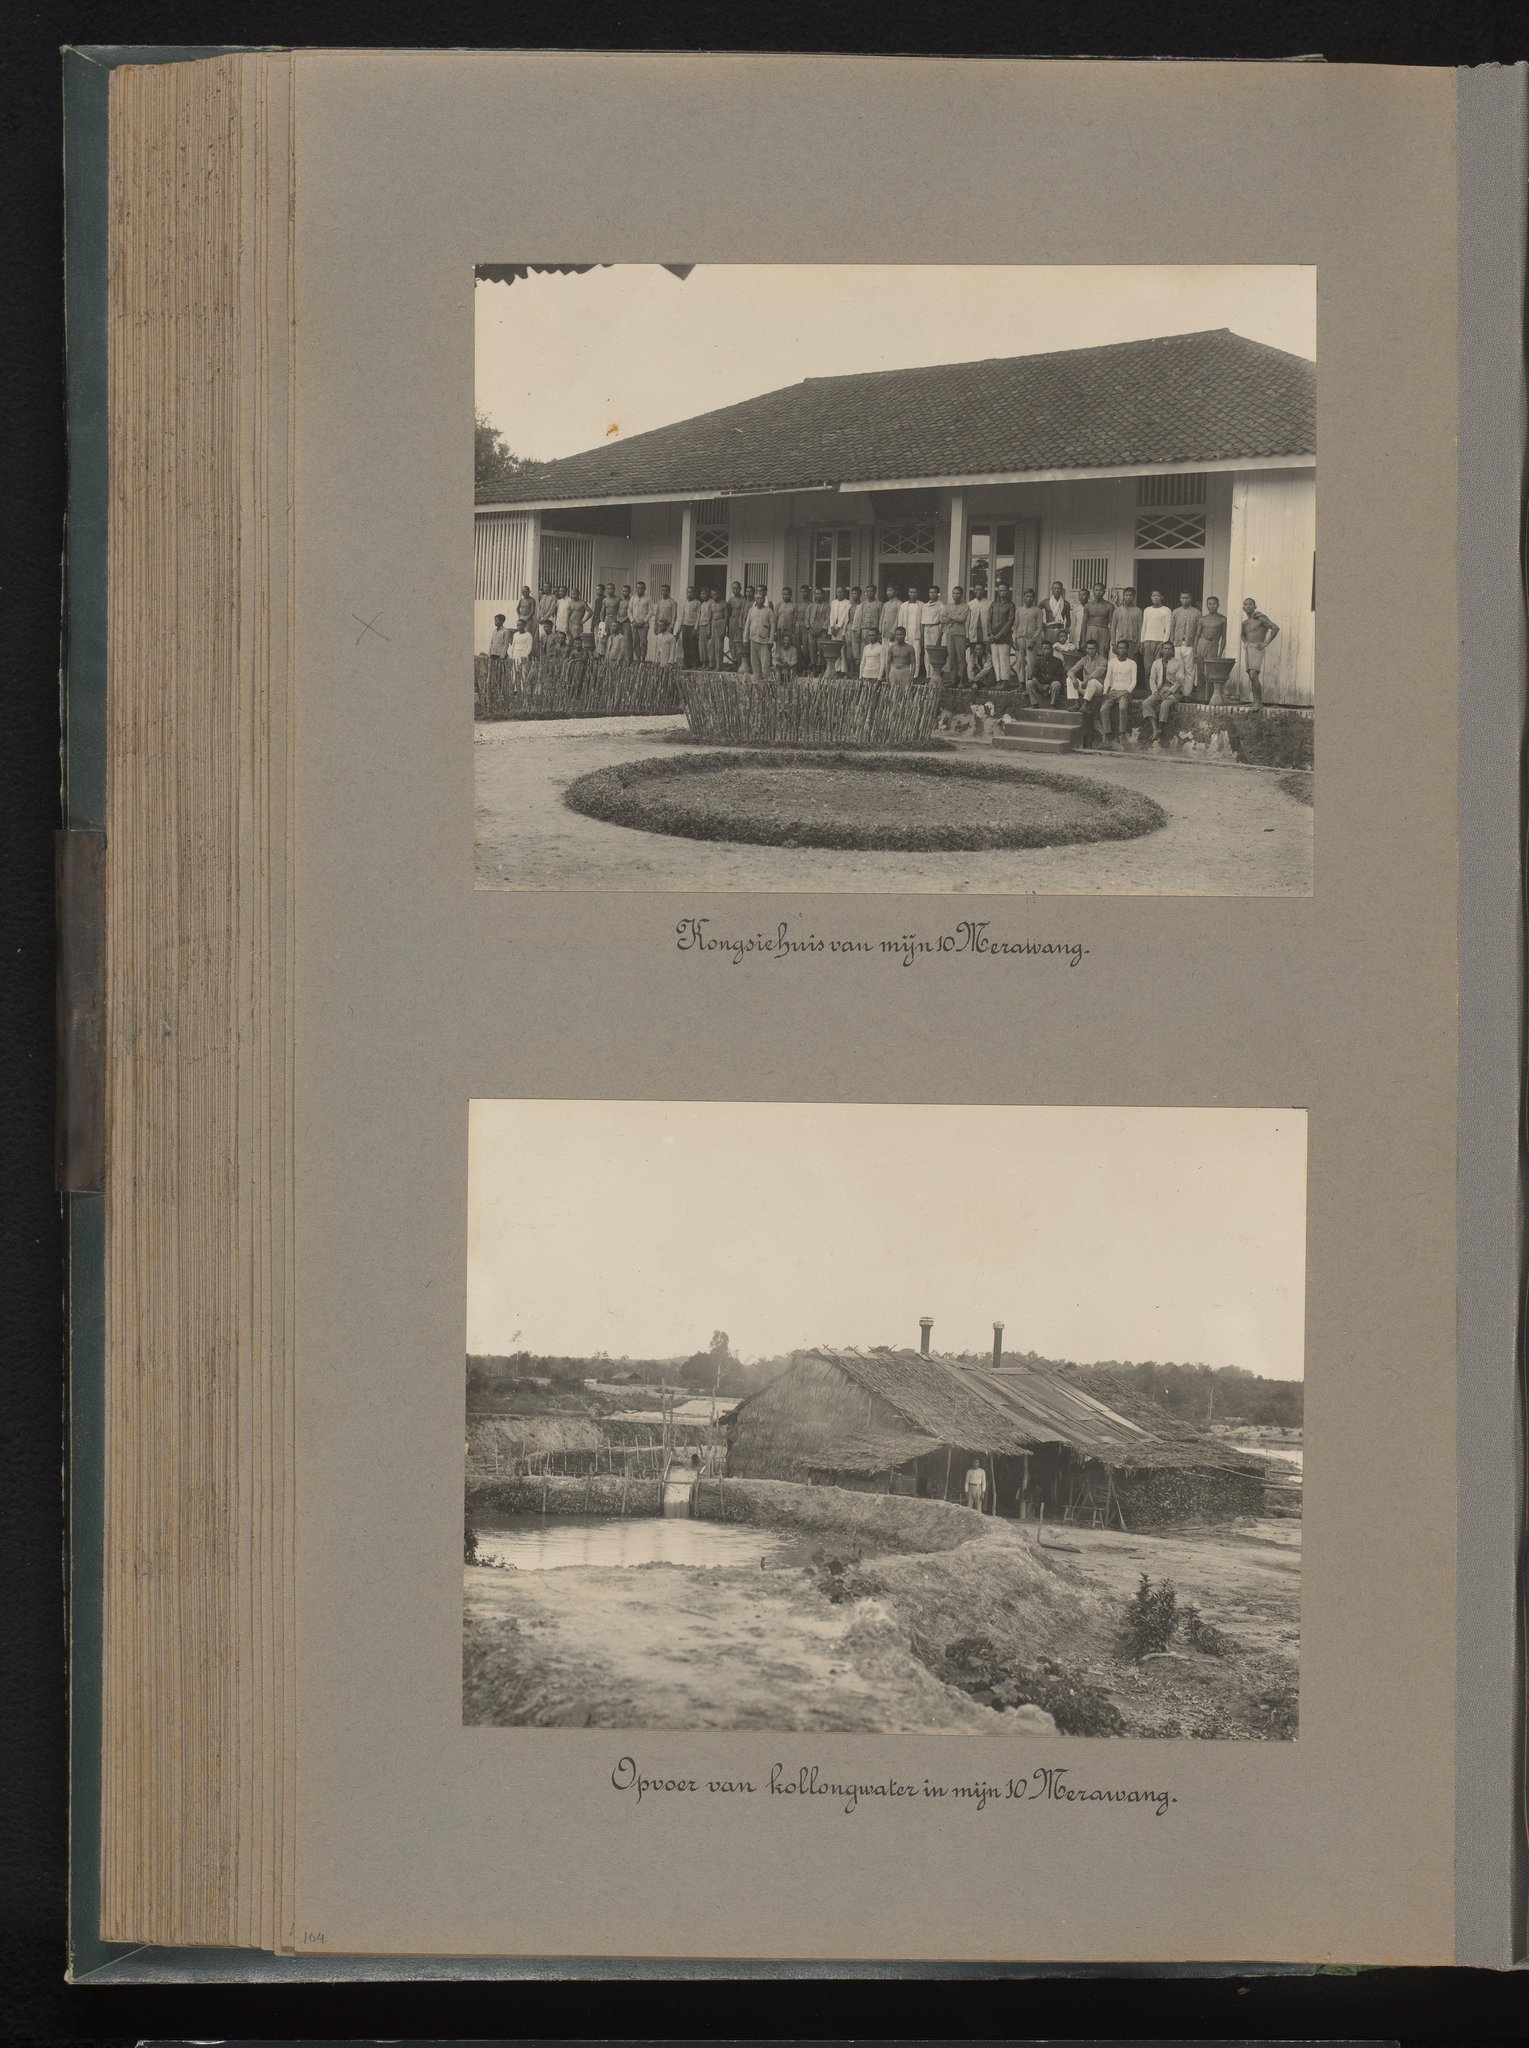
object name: photograph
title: Kongsihuis en waterinstallatie van de Banka-tinwinning te Merawang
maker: Anonymous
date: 1914-1919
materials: cardboard, photographic support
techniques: gelatin silver print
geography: bangka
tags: robert julius boers, colonial system, mining, modern professional organization, trade union, working class, labourers, hut, cabin, lodge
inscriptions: inscription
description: Albumblad met 2 foto's van contractarbeiders poserend voor een kongsihuis en een waterinstallatie van de Banka-tinwinning te Merawang. Onderdeel van het fotoalbum aangeboden aan Robert Julius Boers bij zijn vertrek naar Nederland in 1919 door het personeel van de Banka-tinwinning.